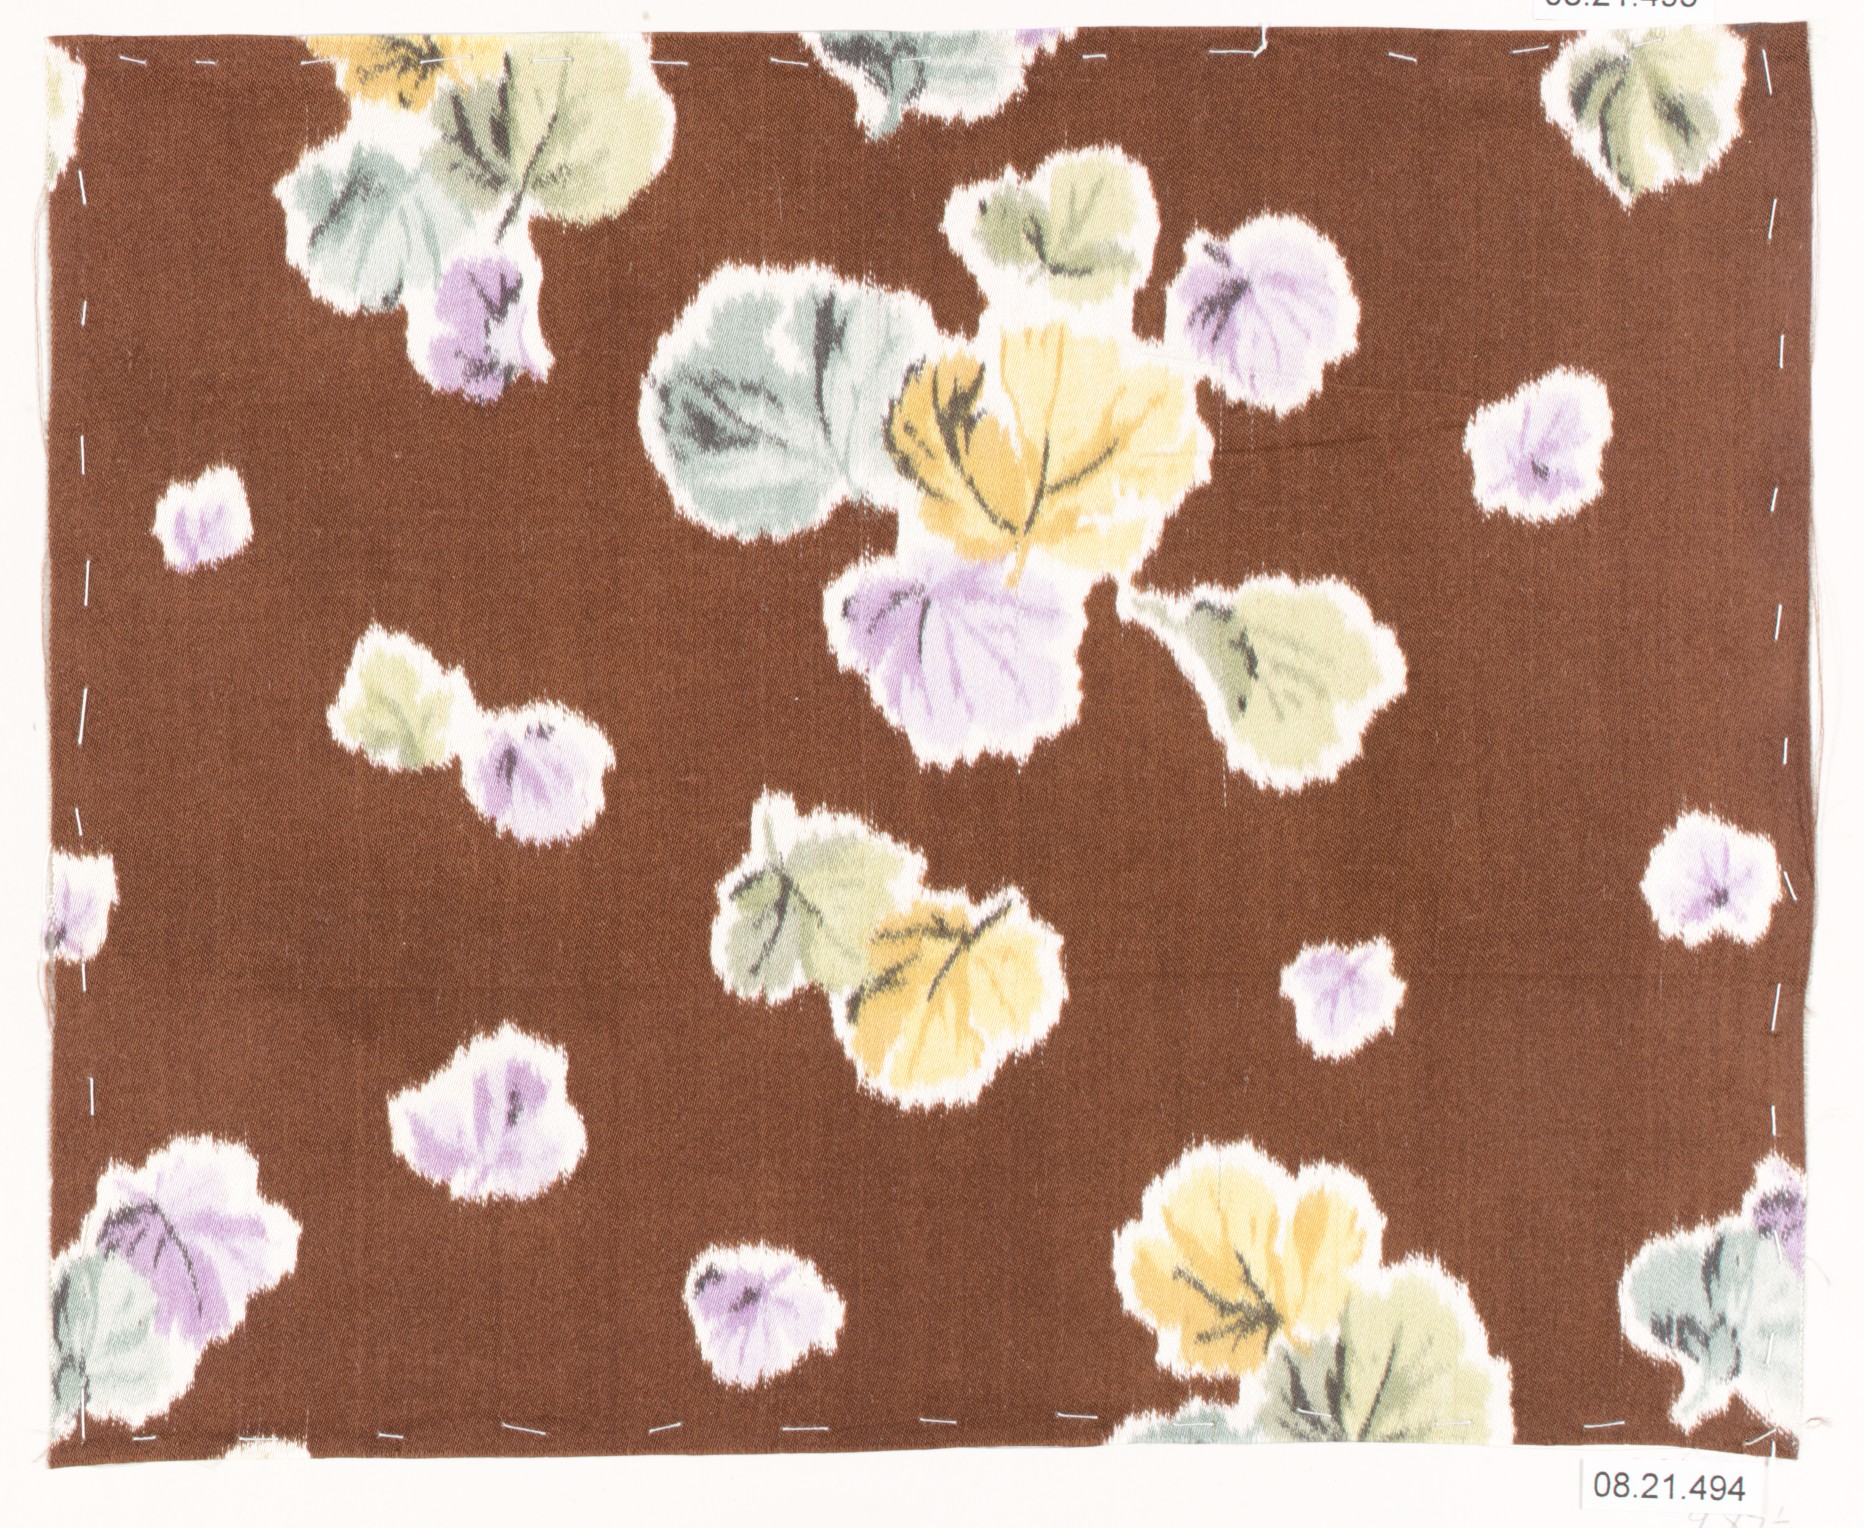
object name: textile sample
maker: Anonymous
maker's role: designer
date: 1900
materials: silk